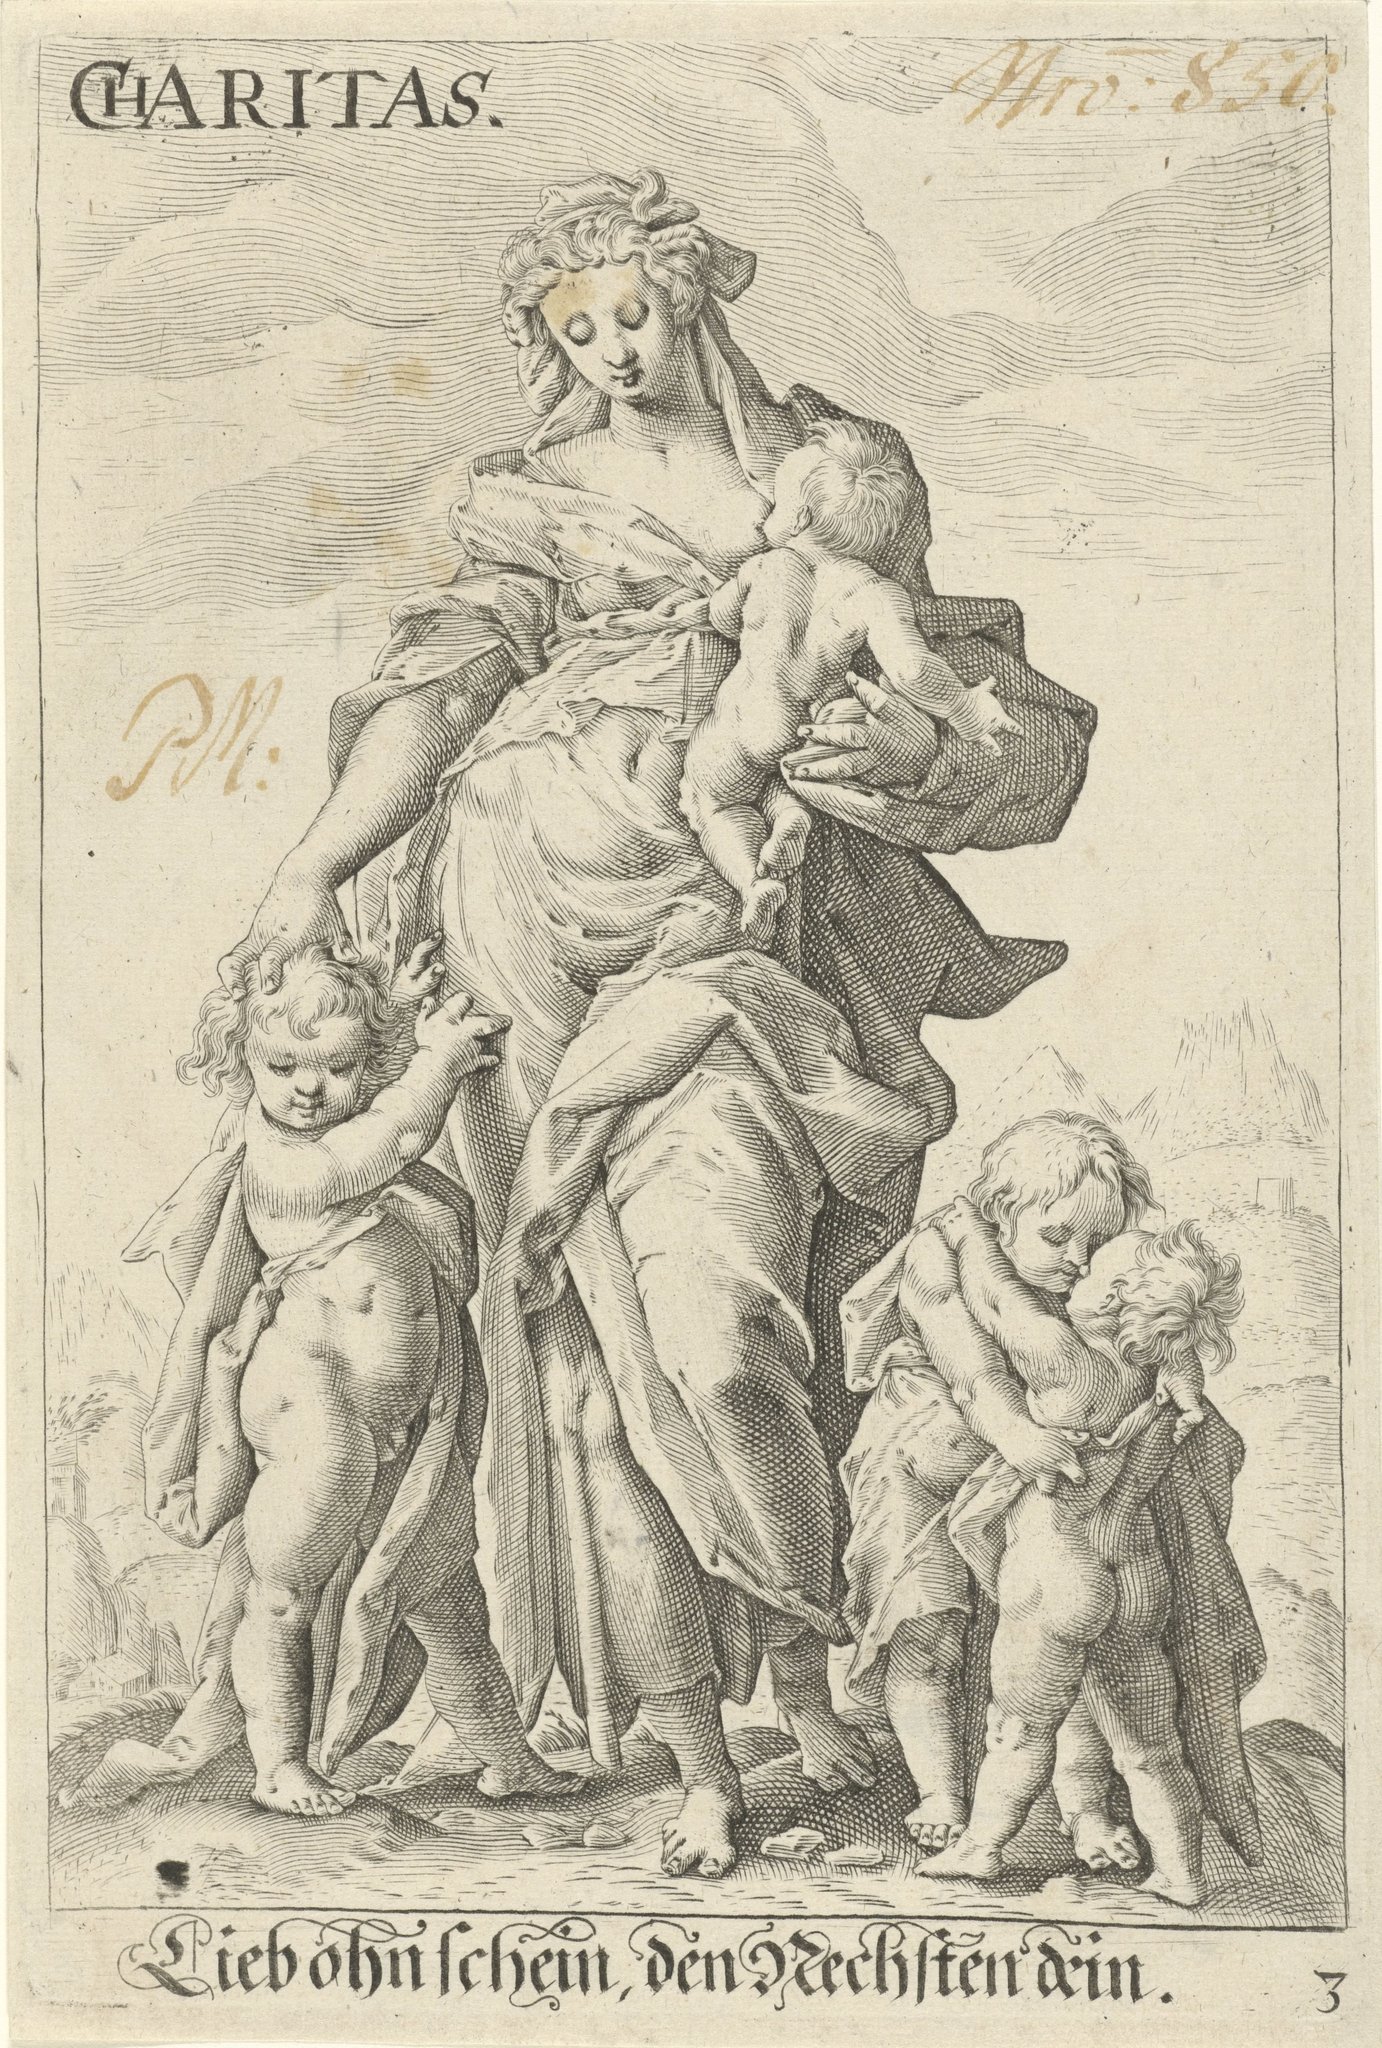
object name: print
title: Liefde (Caritas)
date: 1587-1637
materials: paper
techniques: engraving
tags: charity, 'caritas'; 'carità' (ripa) ~ one of the three theological virtues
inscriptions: initials: ‘PM:’, number: ‘Nro:850’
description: De gepersonifieerde Liefde; een vrouwenfiguur omringd met kinderen.